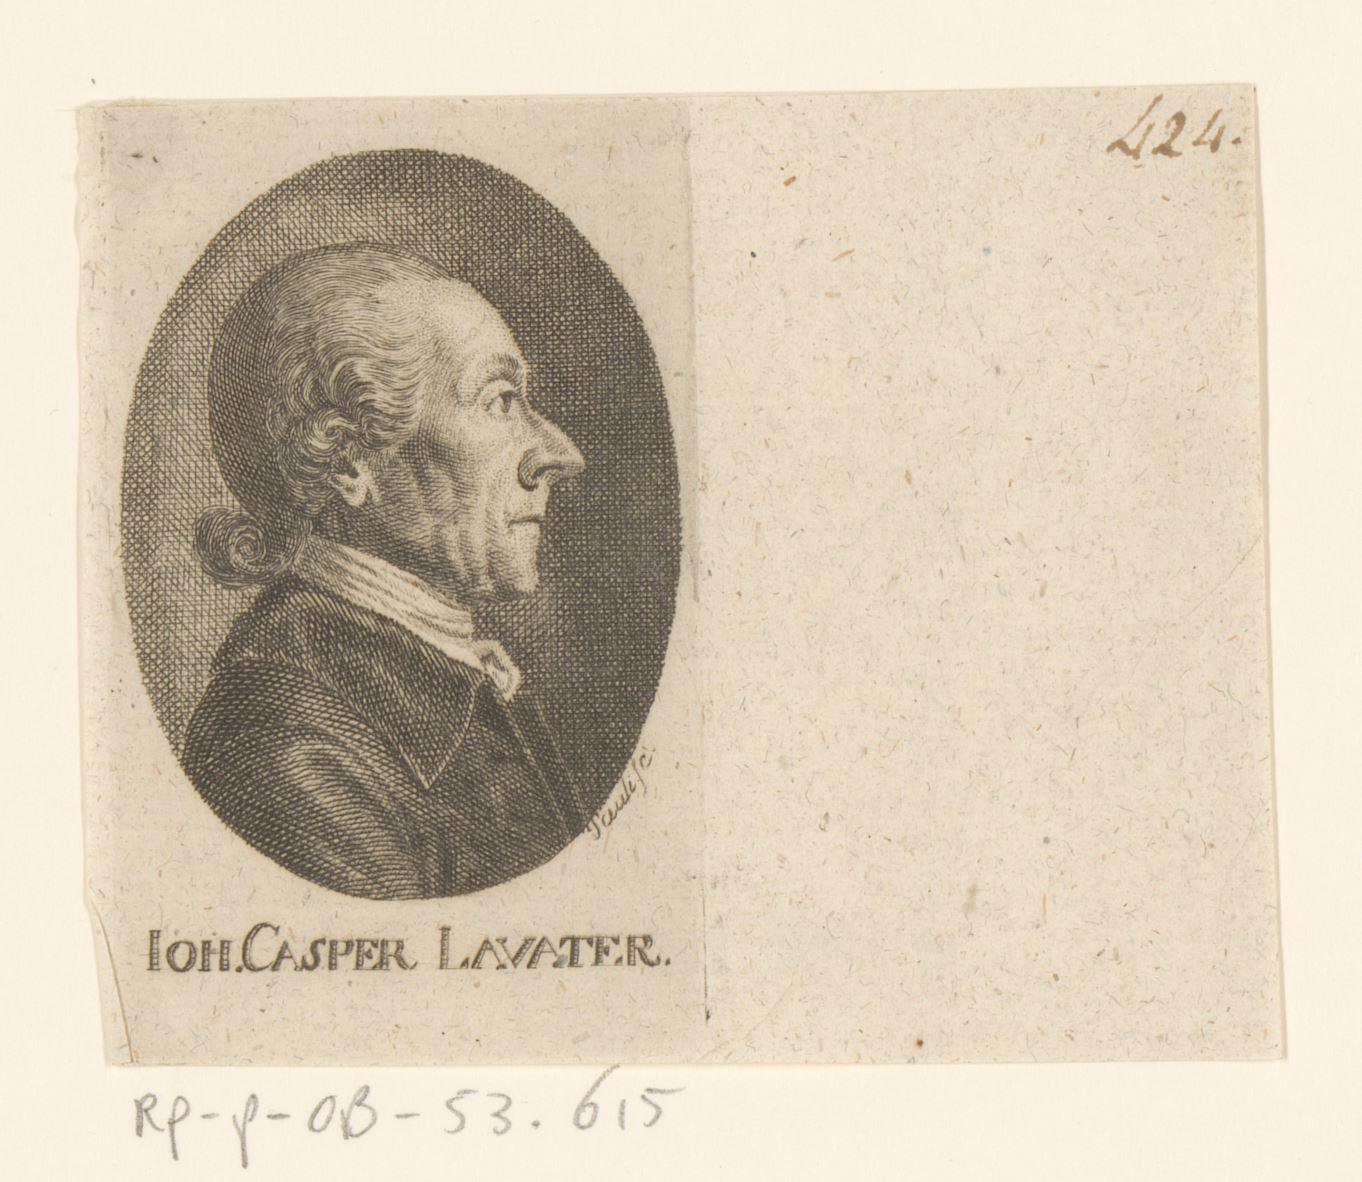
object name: print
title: Portret van Johann Kaspar Lavater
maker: jan willem paulus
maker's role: print maker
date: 1750-1849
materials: paper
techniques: engraving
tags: johann caspar lavater, historical persons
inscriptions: number: ‘424’